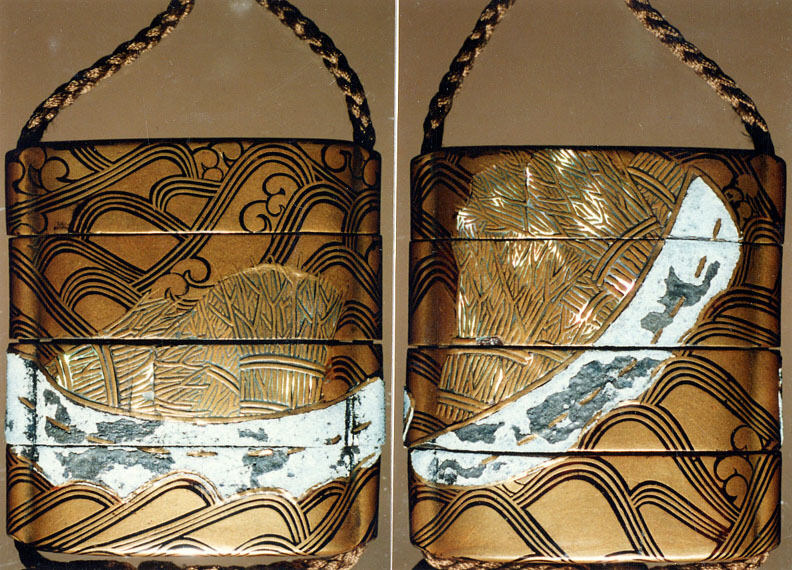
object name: inrō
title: Case (Inrō) with Design of Boat Carrying Brushwood Bundles over Waves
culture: japanese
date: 1701-1900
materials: gold, lacquer, pewter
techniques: fundame, hiramakie, inlay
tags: waves,boats